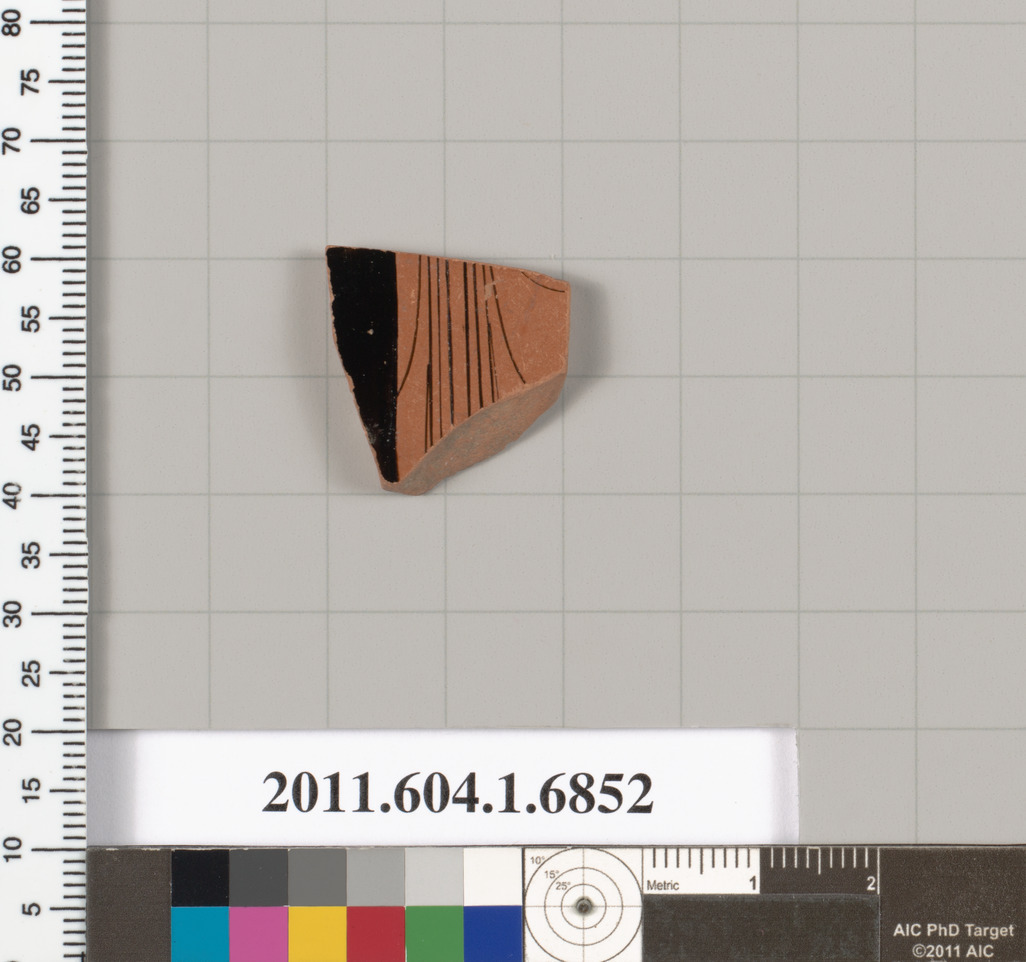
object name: kylix fragment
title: Terracotta fragment of a kylix (drinking cup)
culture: greek, attic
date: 490-470 BCE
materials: terracotta